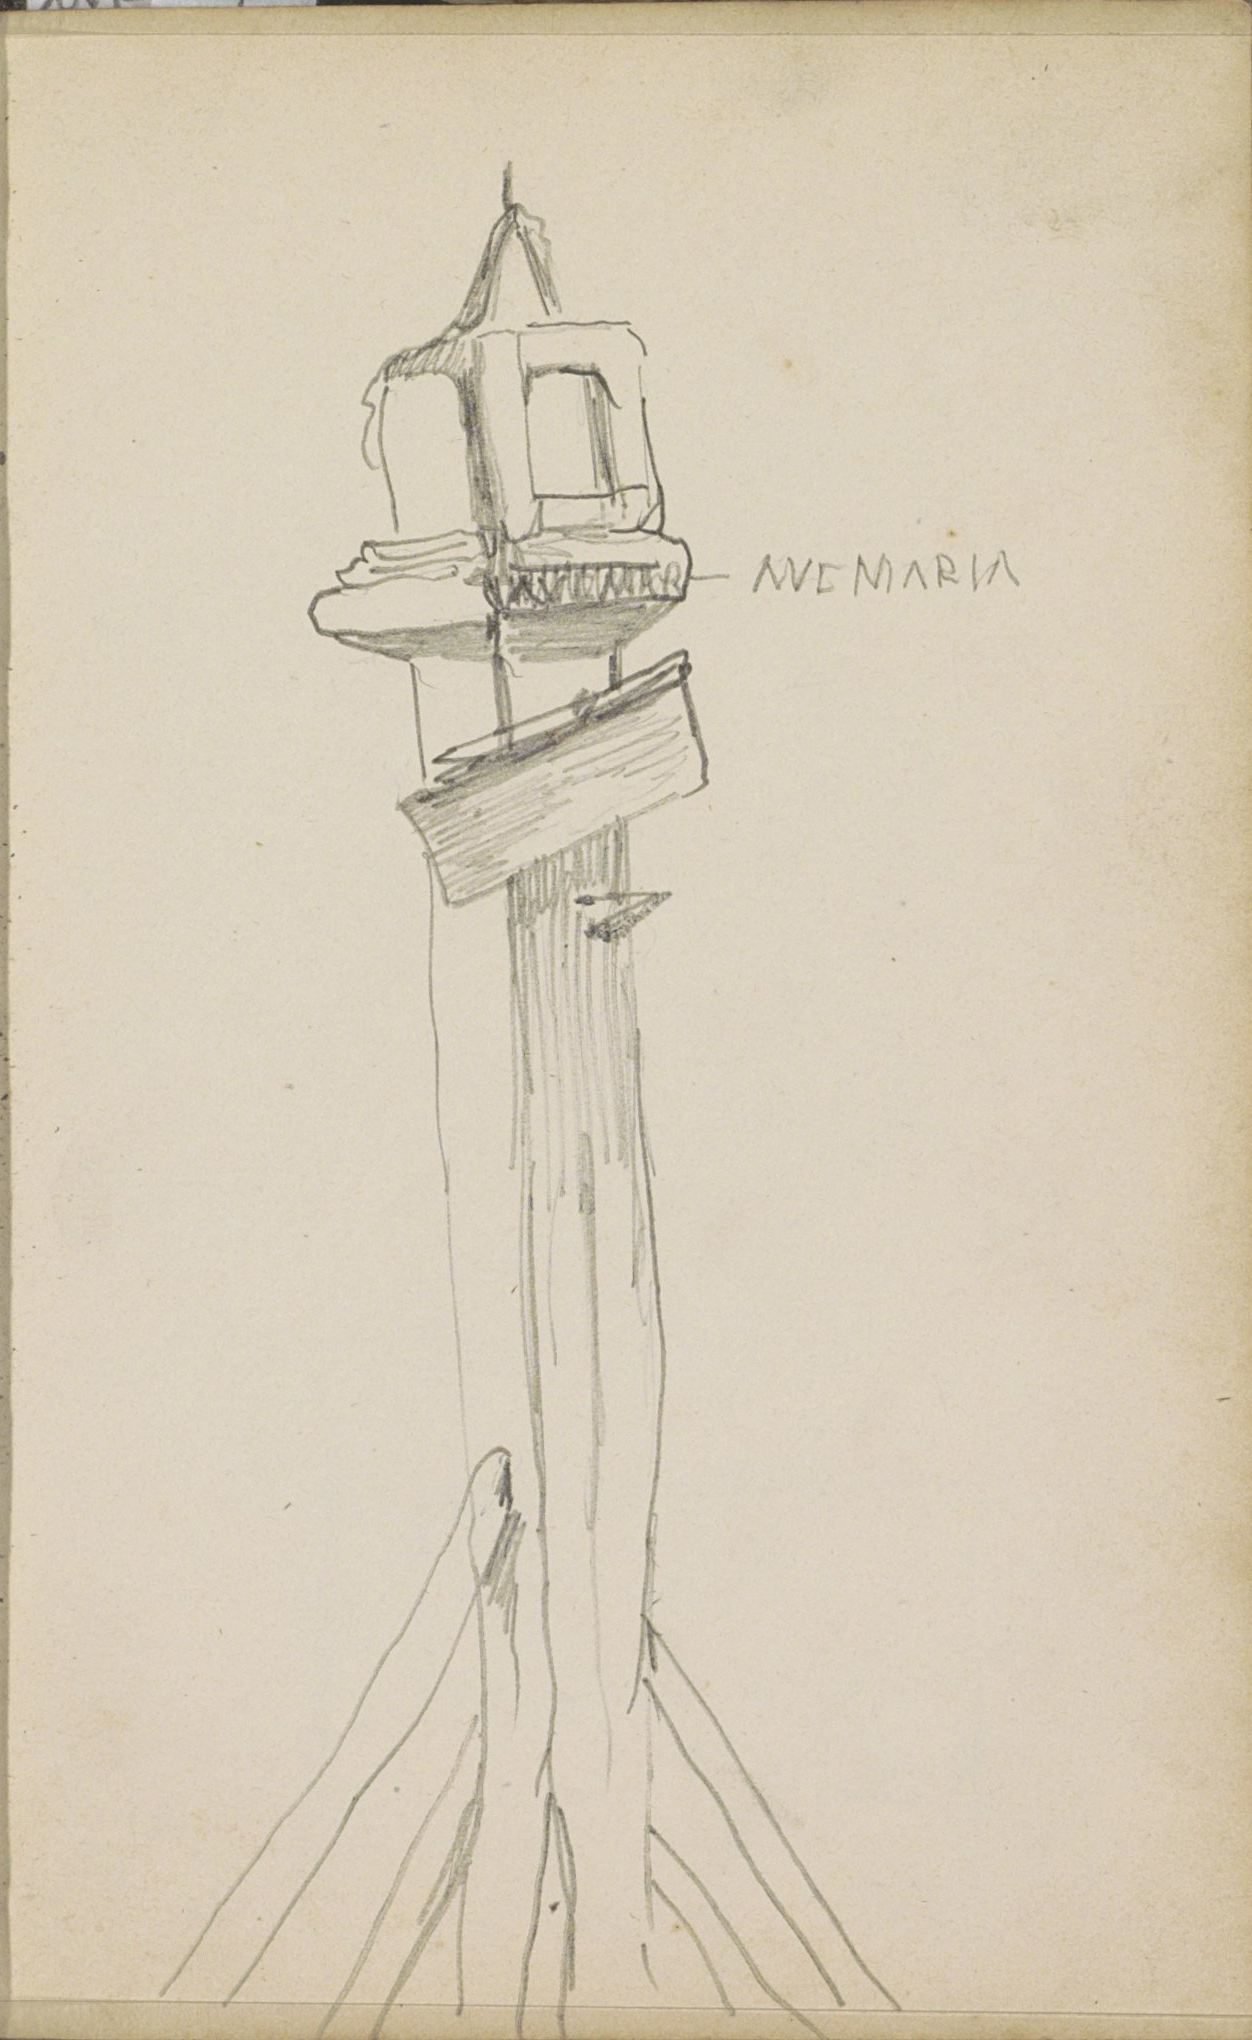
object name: sketchbook leaf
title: Paal met een altaar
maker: johannes tavenraat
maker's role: draughtsman, painter, print maker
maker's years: 1809-1881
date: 1839-1872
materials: paper, pencil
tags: altar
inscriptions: annotation: ‘AVE MARIA’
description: Blad 13 recto uit een schetsboek met 73 bladen.